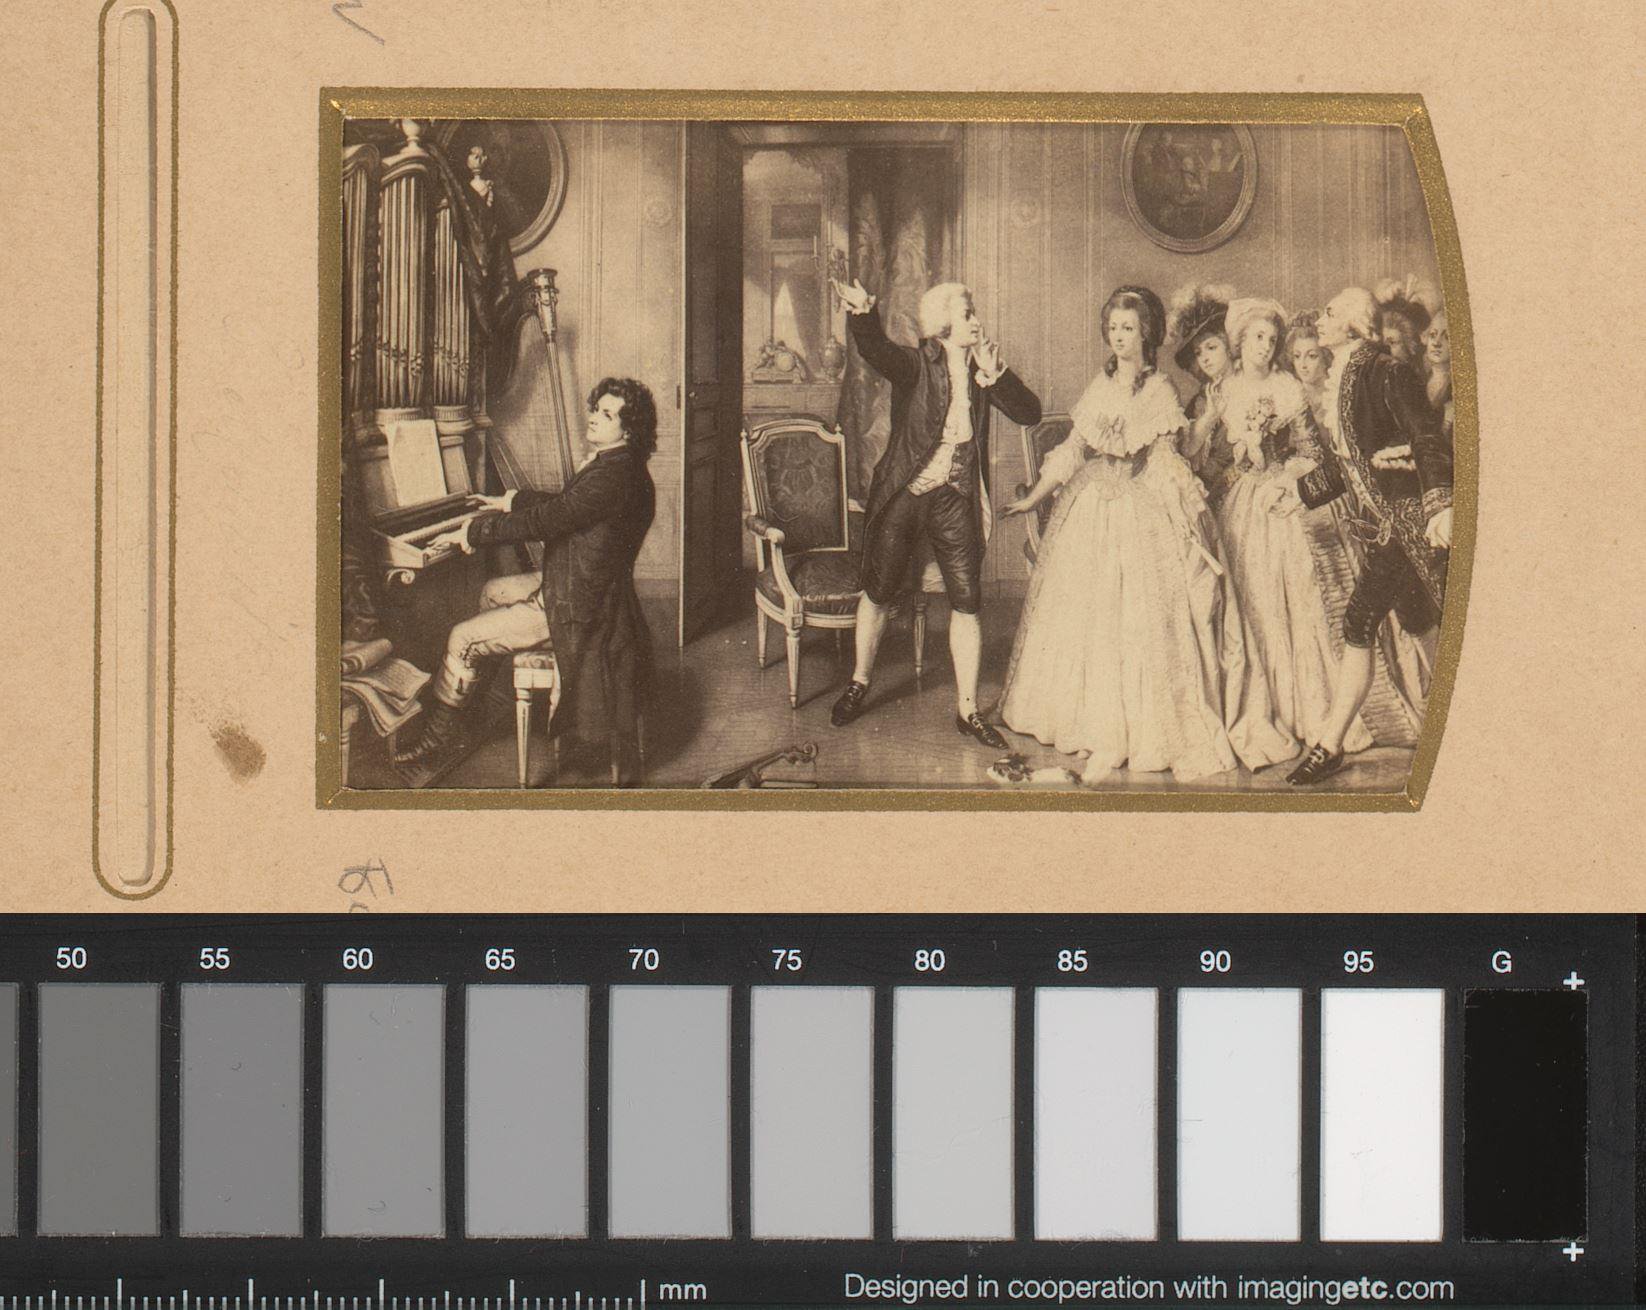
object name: photograph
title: Fotoreproductie van een schilderij van een gezelschap met pianist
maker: Anonymous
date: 1870-1900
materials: cardboard, photographic support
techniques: albumen print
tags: listening to music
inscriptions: annotation: ‘Beethoven en Mozart/ 940.’